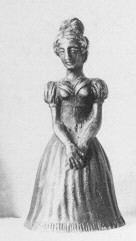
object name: costume bell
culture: french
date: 1801-1900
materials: metal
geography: france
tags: women